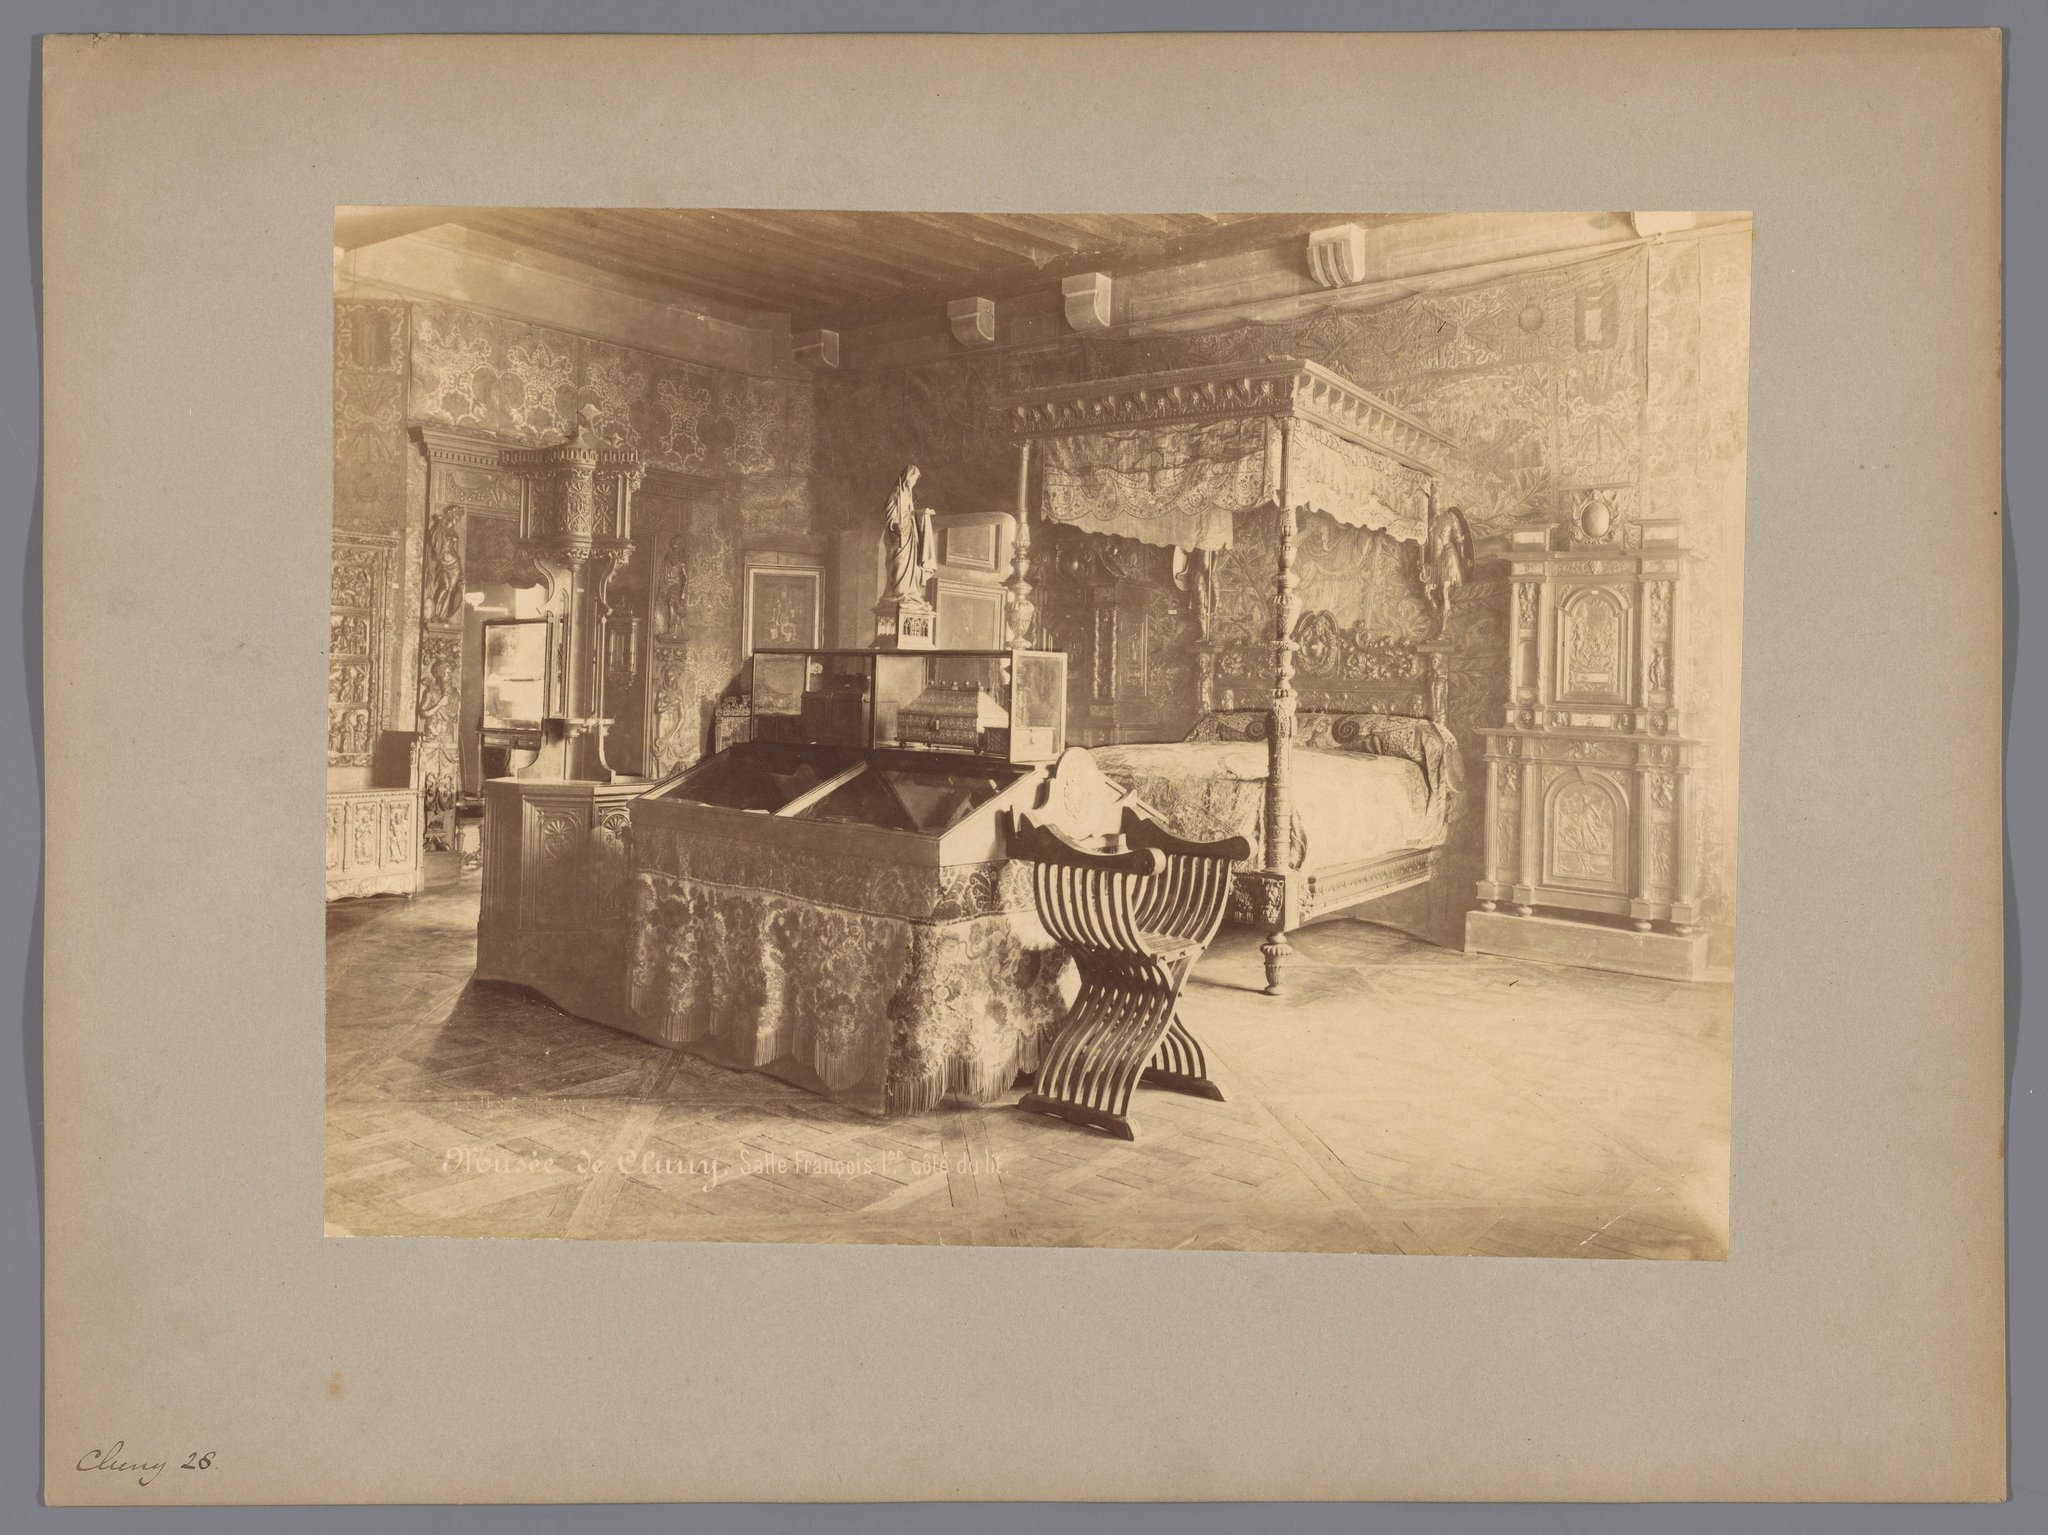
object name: photograph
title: Salle François Ier côte du lit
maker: séraphin-médéric mieusement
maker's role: fotograaf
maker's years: 1840-1905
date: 1850-1900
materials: cardboard, photographic support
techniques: albumen print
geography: paris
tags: permanent exhibition, museum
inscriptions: workshop stamp: ‘Mieusement/ Photographe’, number: ‘Cluny 28’, collector's mark: ‘Rijks-normaalschool voor teekenonderwijzers Amsterdam’ Lugt 3937